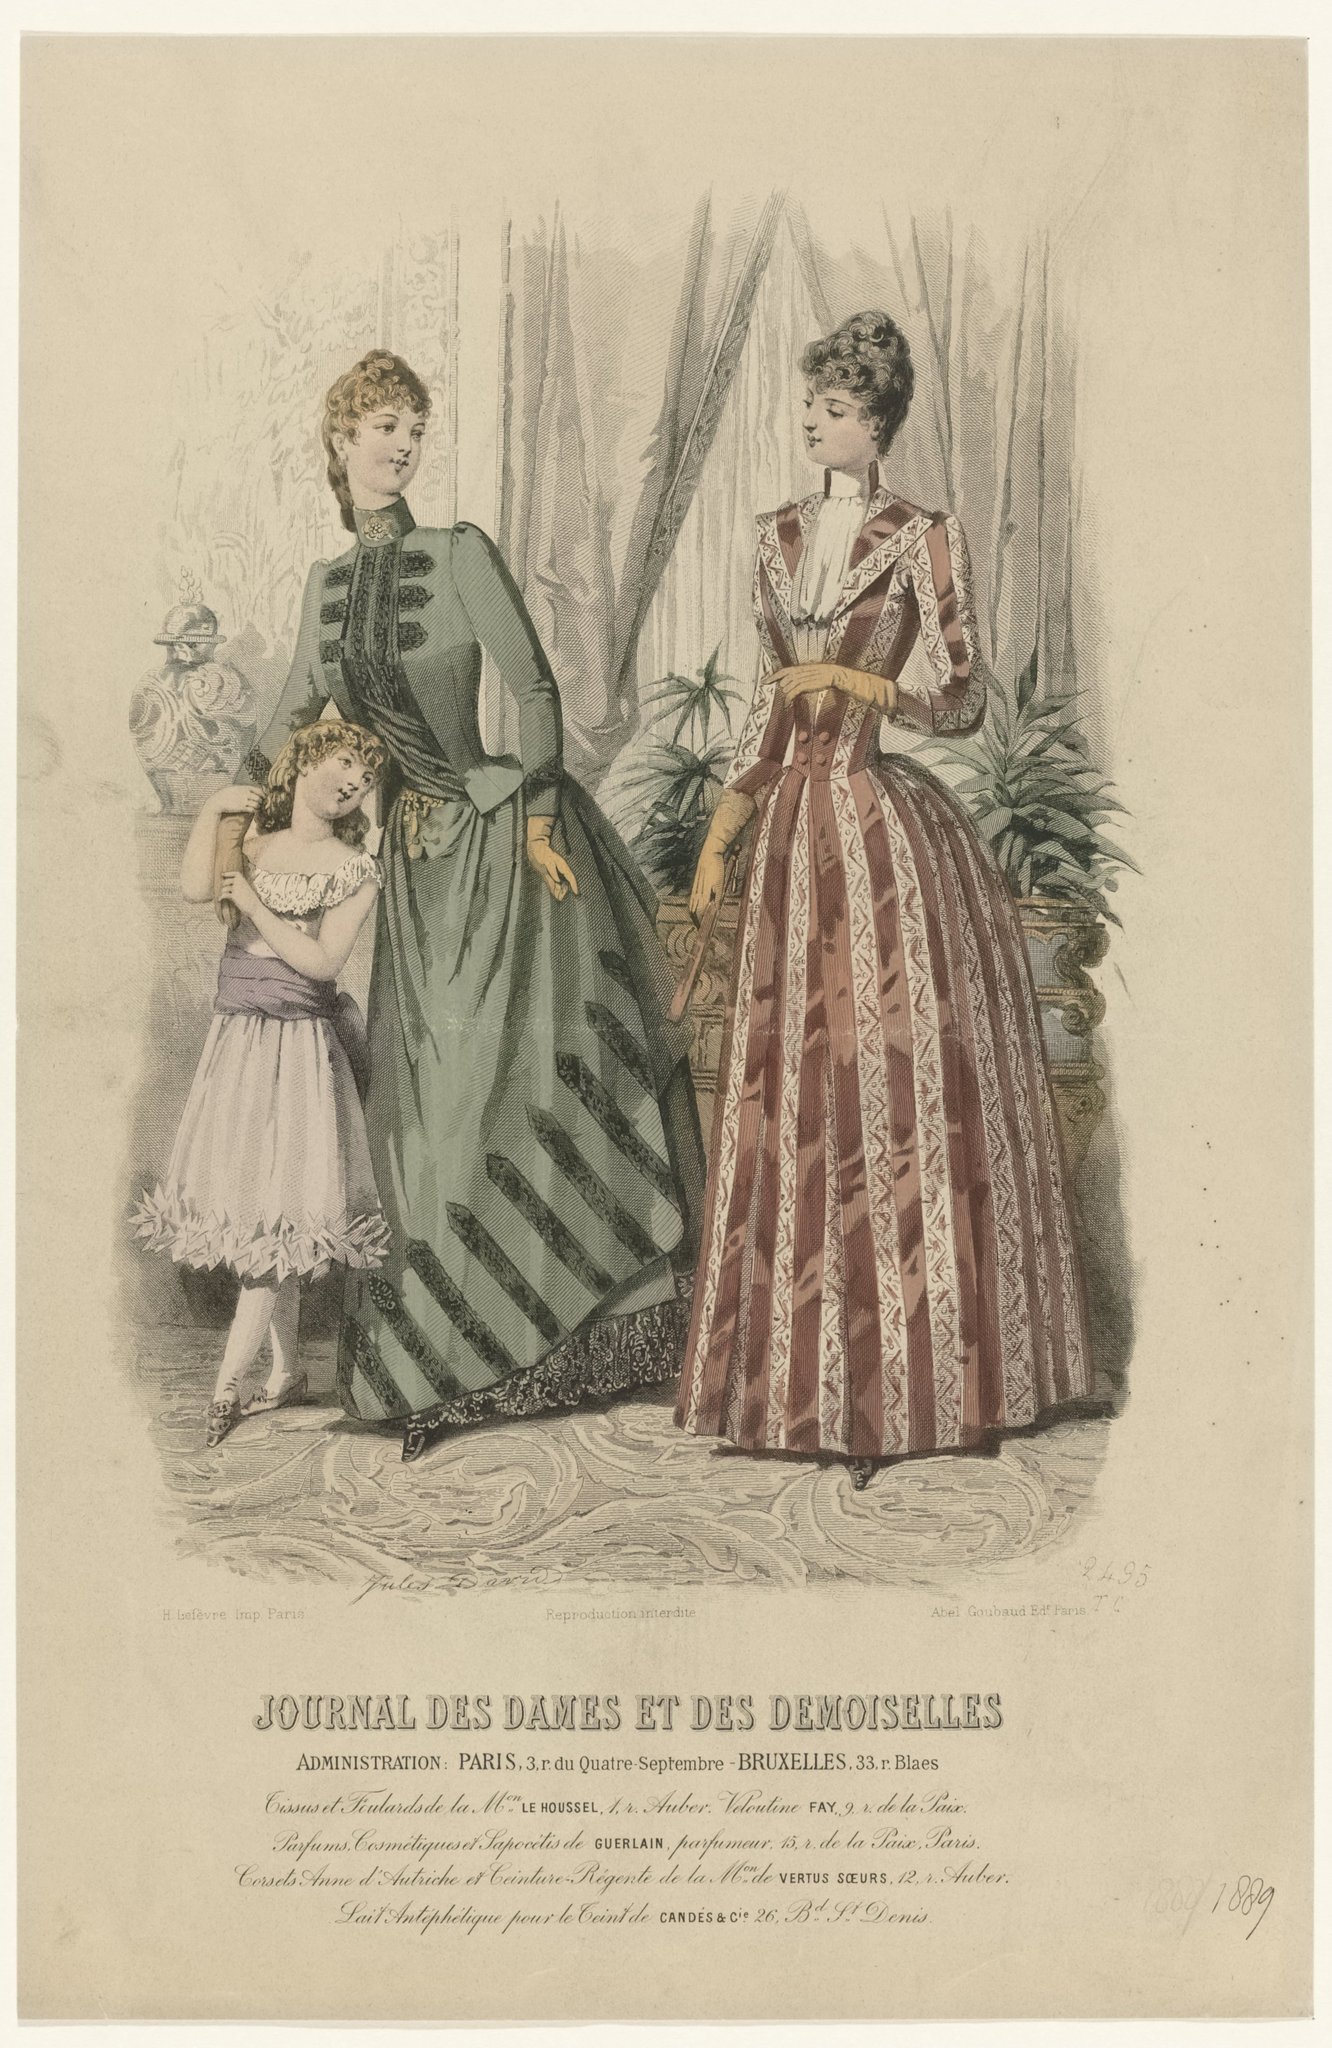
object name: fashion print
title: Journal des Dames et des Demoiselles, 1888-1889, No. 2495: Tissus et Foulards de la M.on LE HOUSSEL (...)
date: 1888-1889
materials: paper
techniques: engraving, hand coloring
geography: paris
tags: brooch, agraffe, clasp (+ women's clothes), gloves, mittens (long gloves) (+ women's clothes), shoes, sandals (+ girls' clothes), belt, girdle, waistband (+ girls' clothes), fashion plates, dress, gown (+ women's clothes), fan (+ women's clothes), dress, gown (+ girls' clothes)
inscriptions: title: ‘JOURNAL DES DAMES ET DES DEMOISELLES’, address: ‘ADMINISTRATION: PARIS, 3,r. du Quatre-Septembre-BRUXELLES, 33, r. Blaes’, caption: ‘Tissus et Foulards de la M.on LE HOUSSEL, 1, r. Auber. Veloutine FAY, 9, r. de la Paix. Parfums, Cosmetiques et Sapocétis de GUERLAIN, parfumeur, 15, r. de la Paix, Paris. Corsets Anne d'Autriche et Ceinture-Régente de la M.on de VERTUS SOEURS, 12, r. Auber. Lait Antéphélique pour le Teint de CANDÉS & CIE, 26, B.d S.t Denis.’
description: Twee vrouwen en een meisje in een interieur. Links: kinderkleding; meisje in een jurk met ceintuur. Vrouw in een ensemble: getailleerd jasje, rok met queue. Accessoires: broche, chatelaine, handschoenen. Rechts: japon met streepmotief. Onder de voorstelling enkele regels reclametekst voor verschillende producten. Prent uit het modetijdschrift Journal des Dames et des Demoiselles (1841-1902).